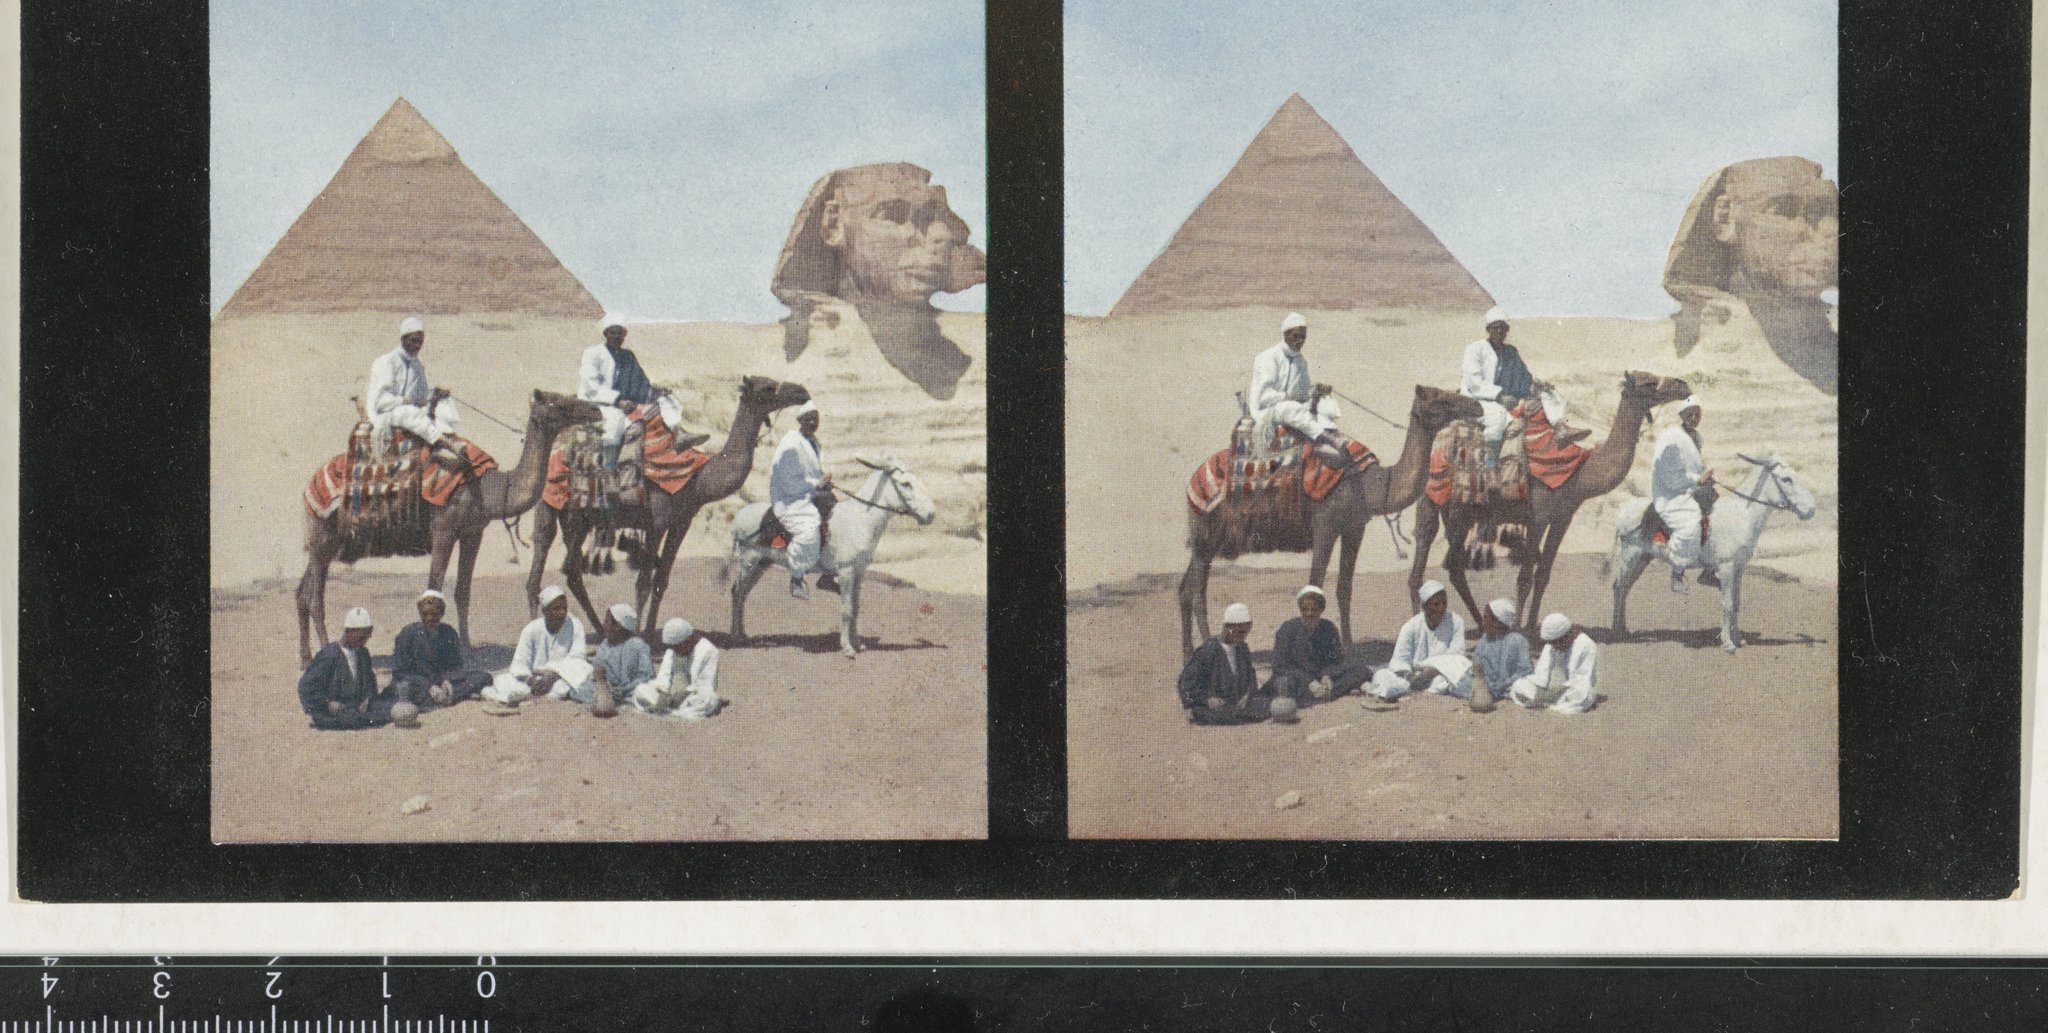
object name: photomechanical print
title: Pyramiden von Gizeh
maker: Anonymous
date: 1911-1919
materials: paper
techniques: three-color autotype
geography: stuttgart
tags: hoofed animals: dromedary, sphinx (lion/woman); 'sfinge' (ripa), pyramid (historical grave form)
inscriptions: inscription: ‘Chromoplast-Bild’, title: ‘Pyramiden von Gizeh.’, number: ‘No. 200’, inscription: ‘Die meisten ägyptischen Pyramiden - Gräber/ der Pharaonen - liegen am Ostabhang der (...)’, inscription: ‘Warenzeichen/ No. 142 123’, inscription: ‘D. R. G. M./ No. 437 756’